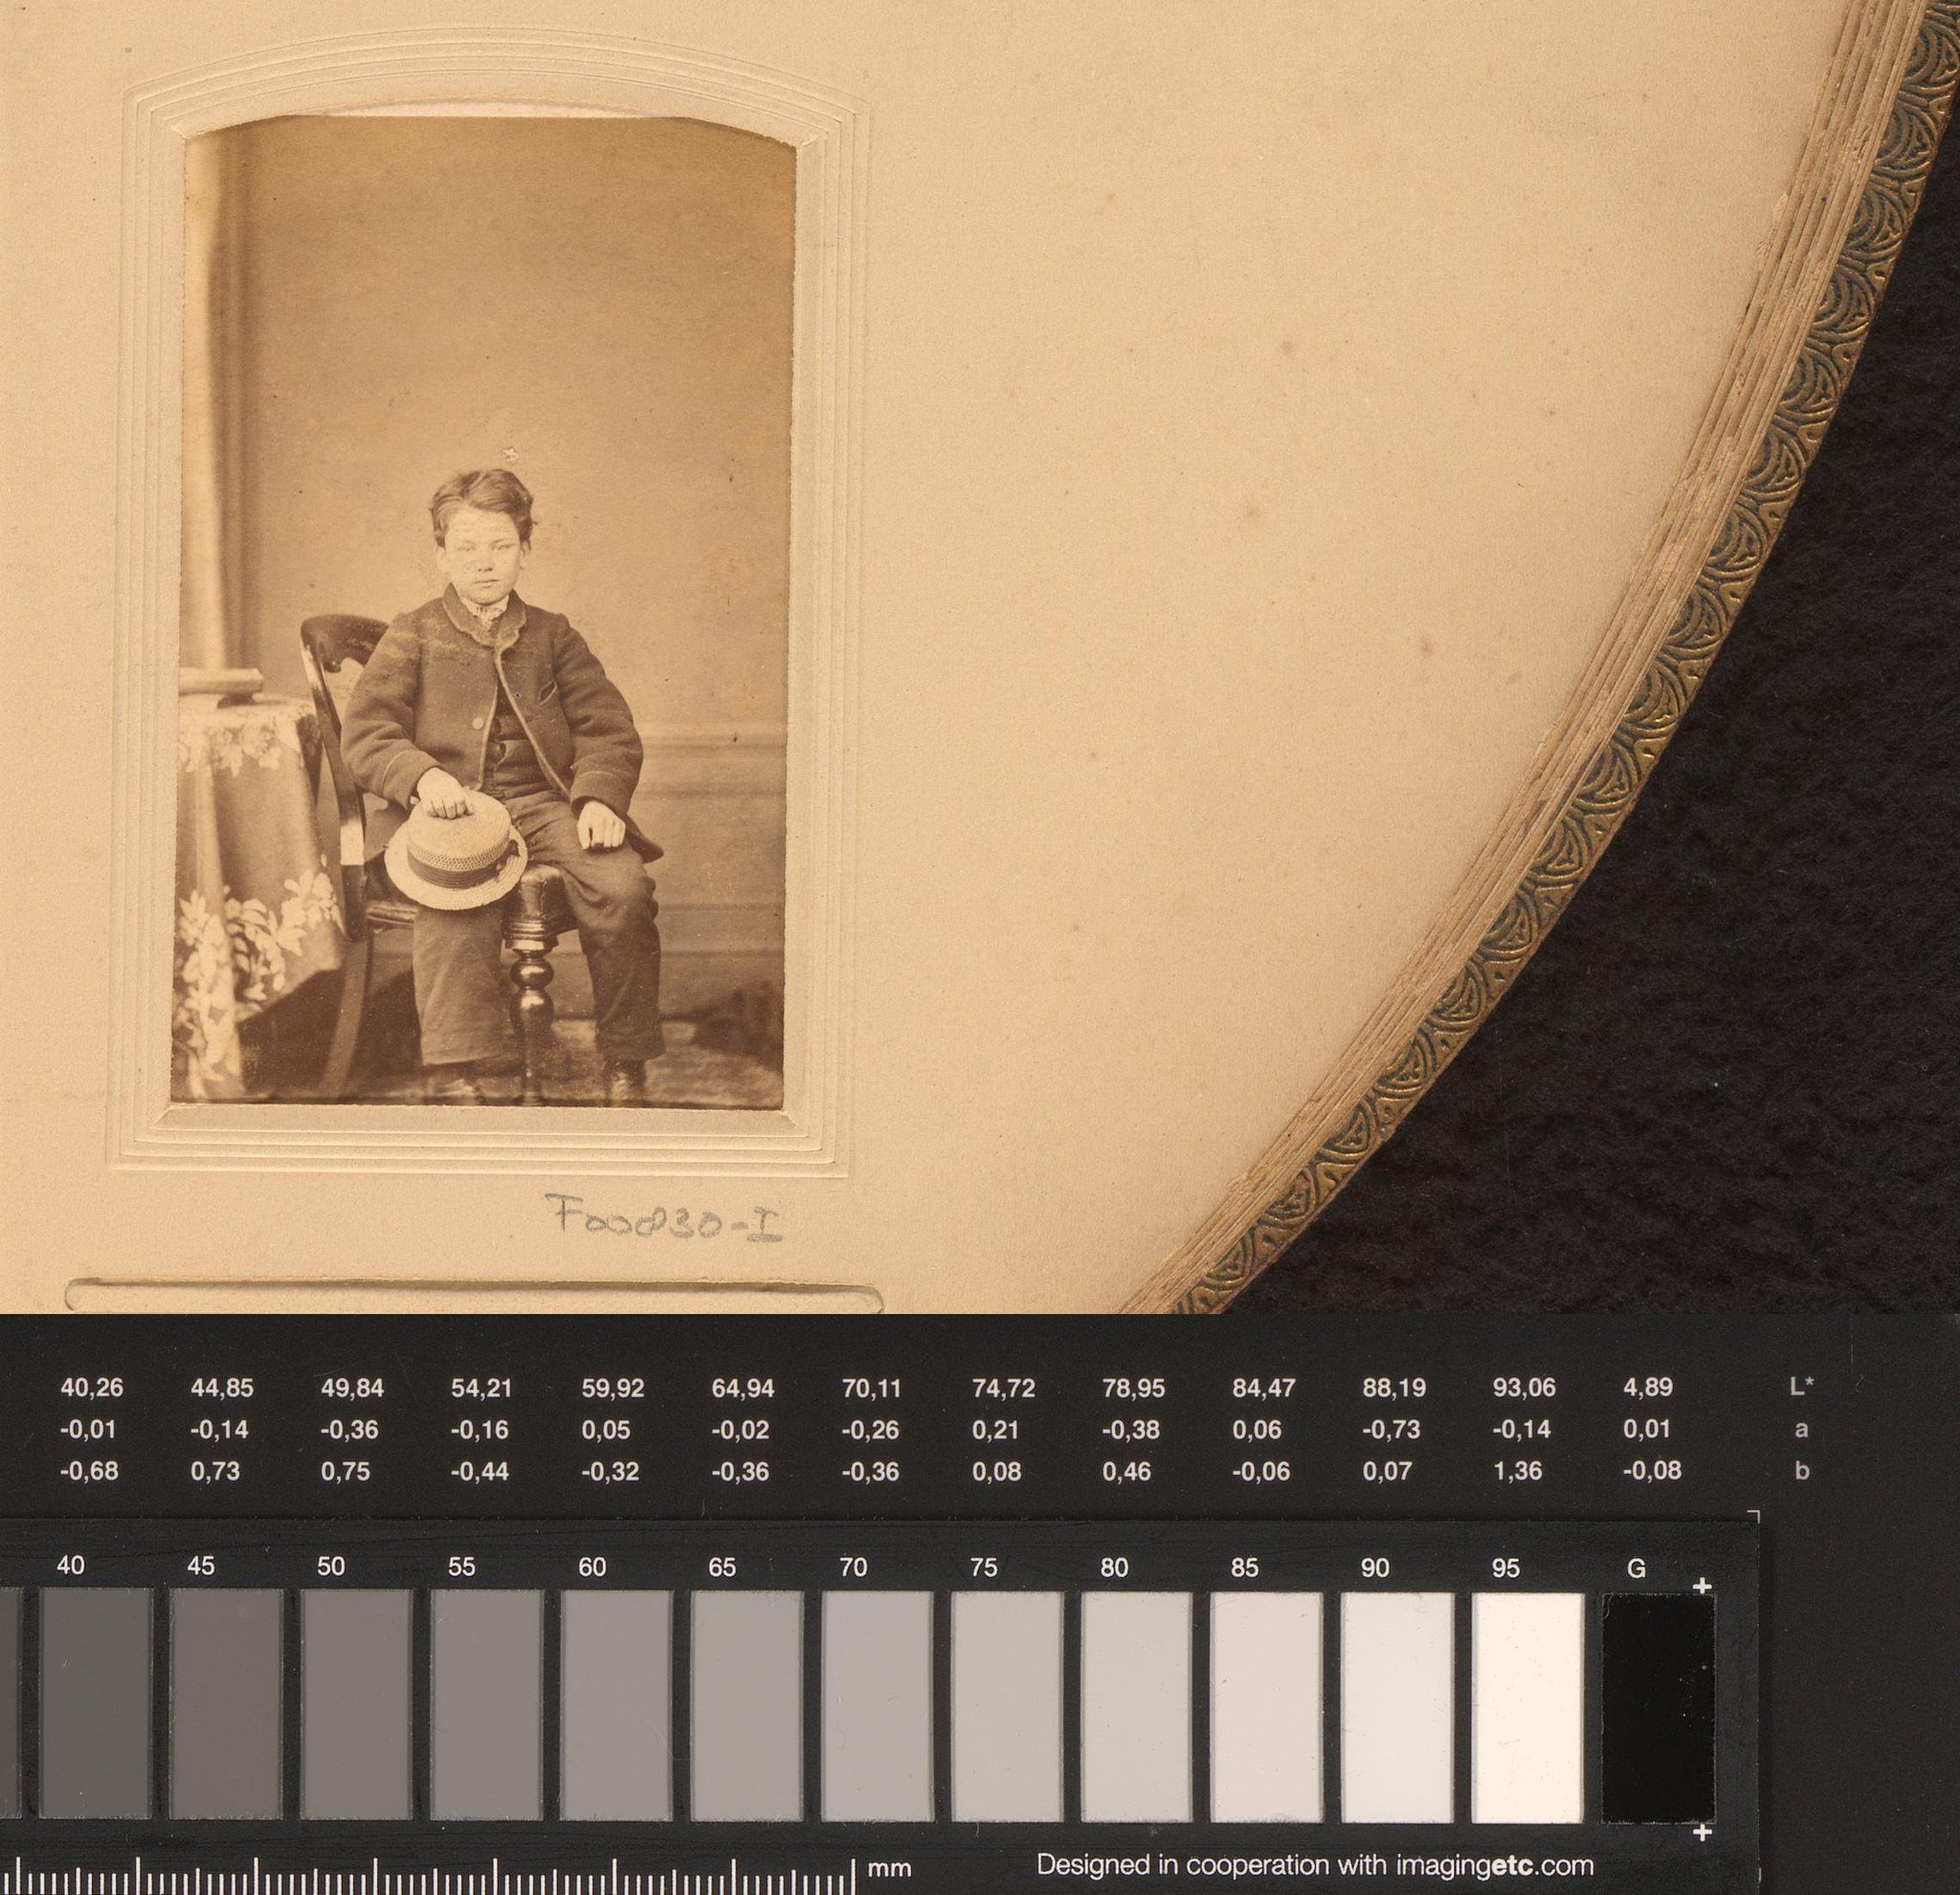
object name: album leaf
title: Portret van David Williams, zittend met een hoed op de knie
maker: Anonymous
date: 1870-1900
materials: cardboard, photographic support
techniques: albumen print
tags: sitting figure, child, historical persons, head-gear: hat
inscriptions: number: ‘15’